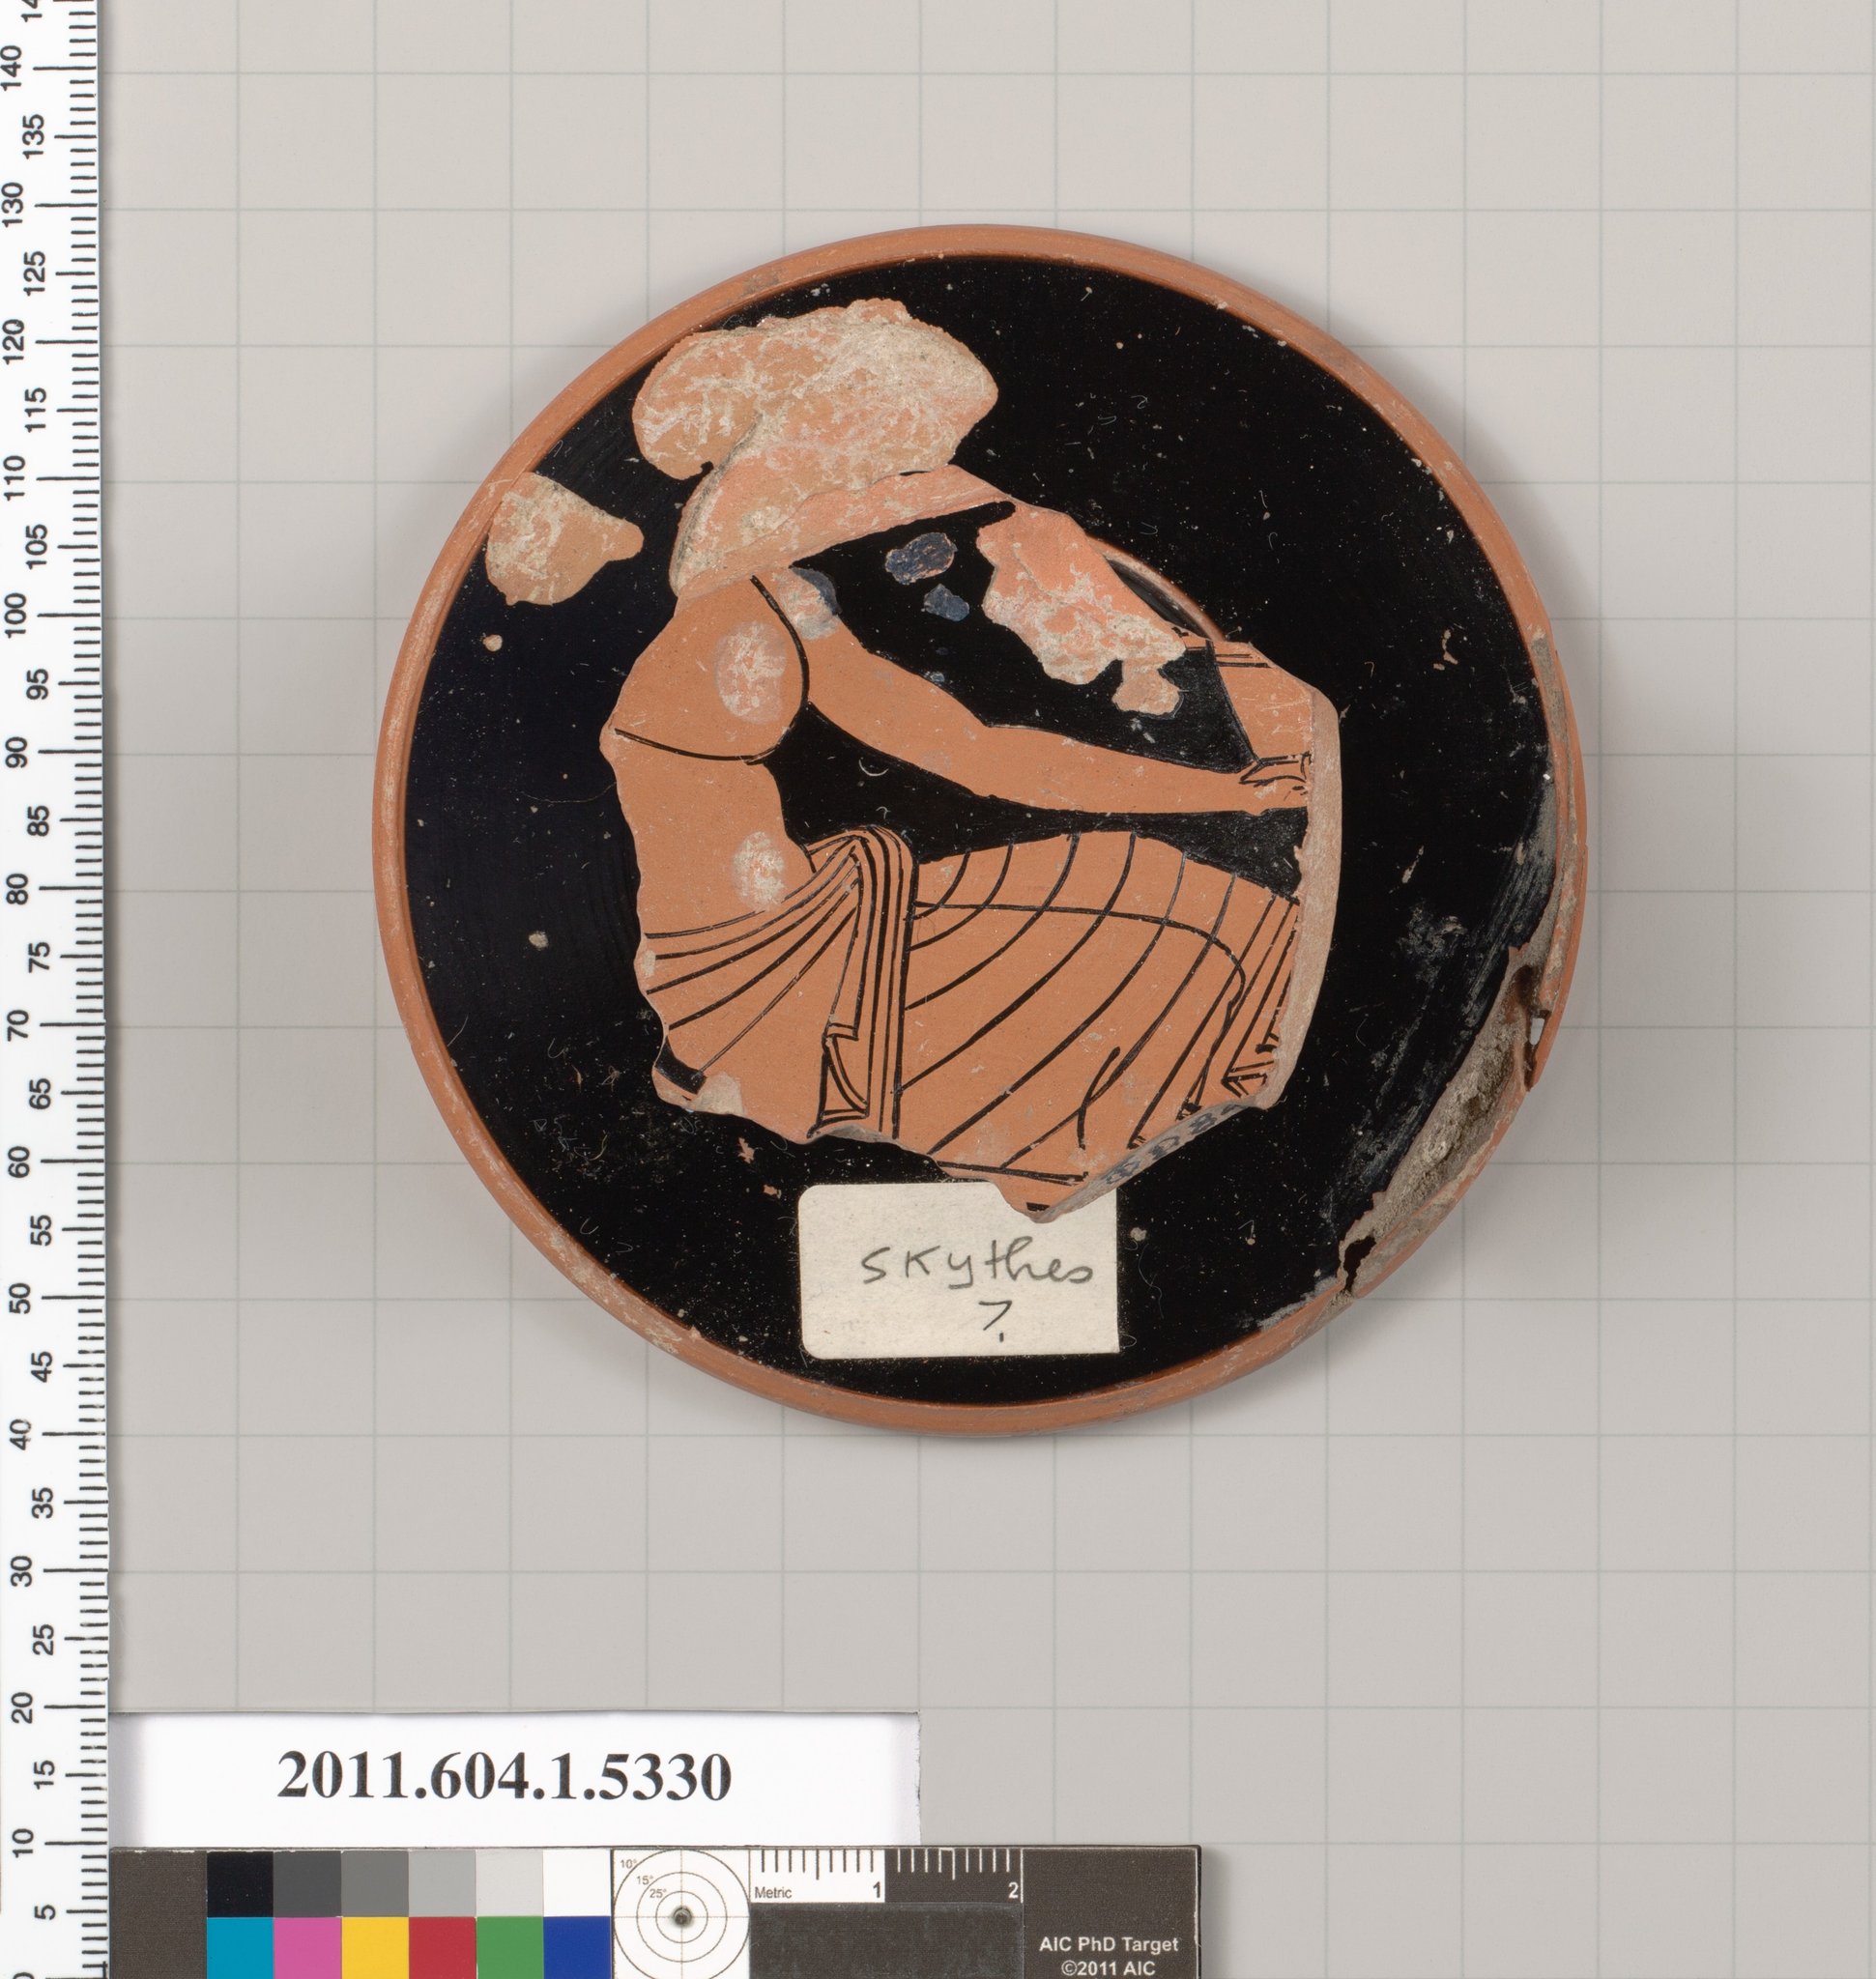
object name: kylix fragment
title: Terracotta fragment of a kylix (drinking cup)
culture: greek, attic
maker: skythes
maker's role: artist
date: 534-468 BCE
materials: terracotta